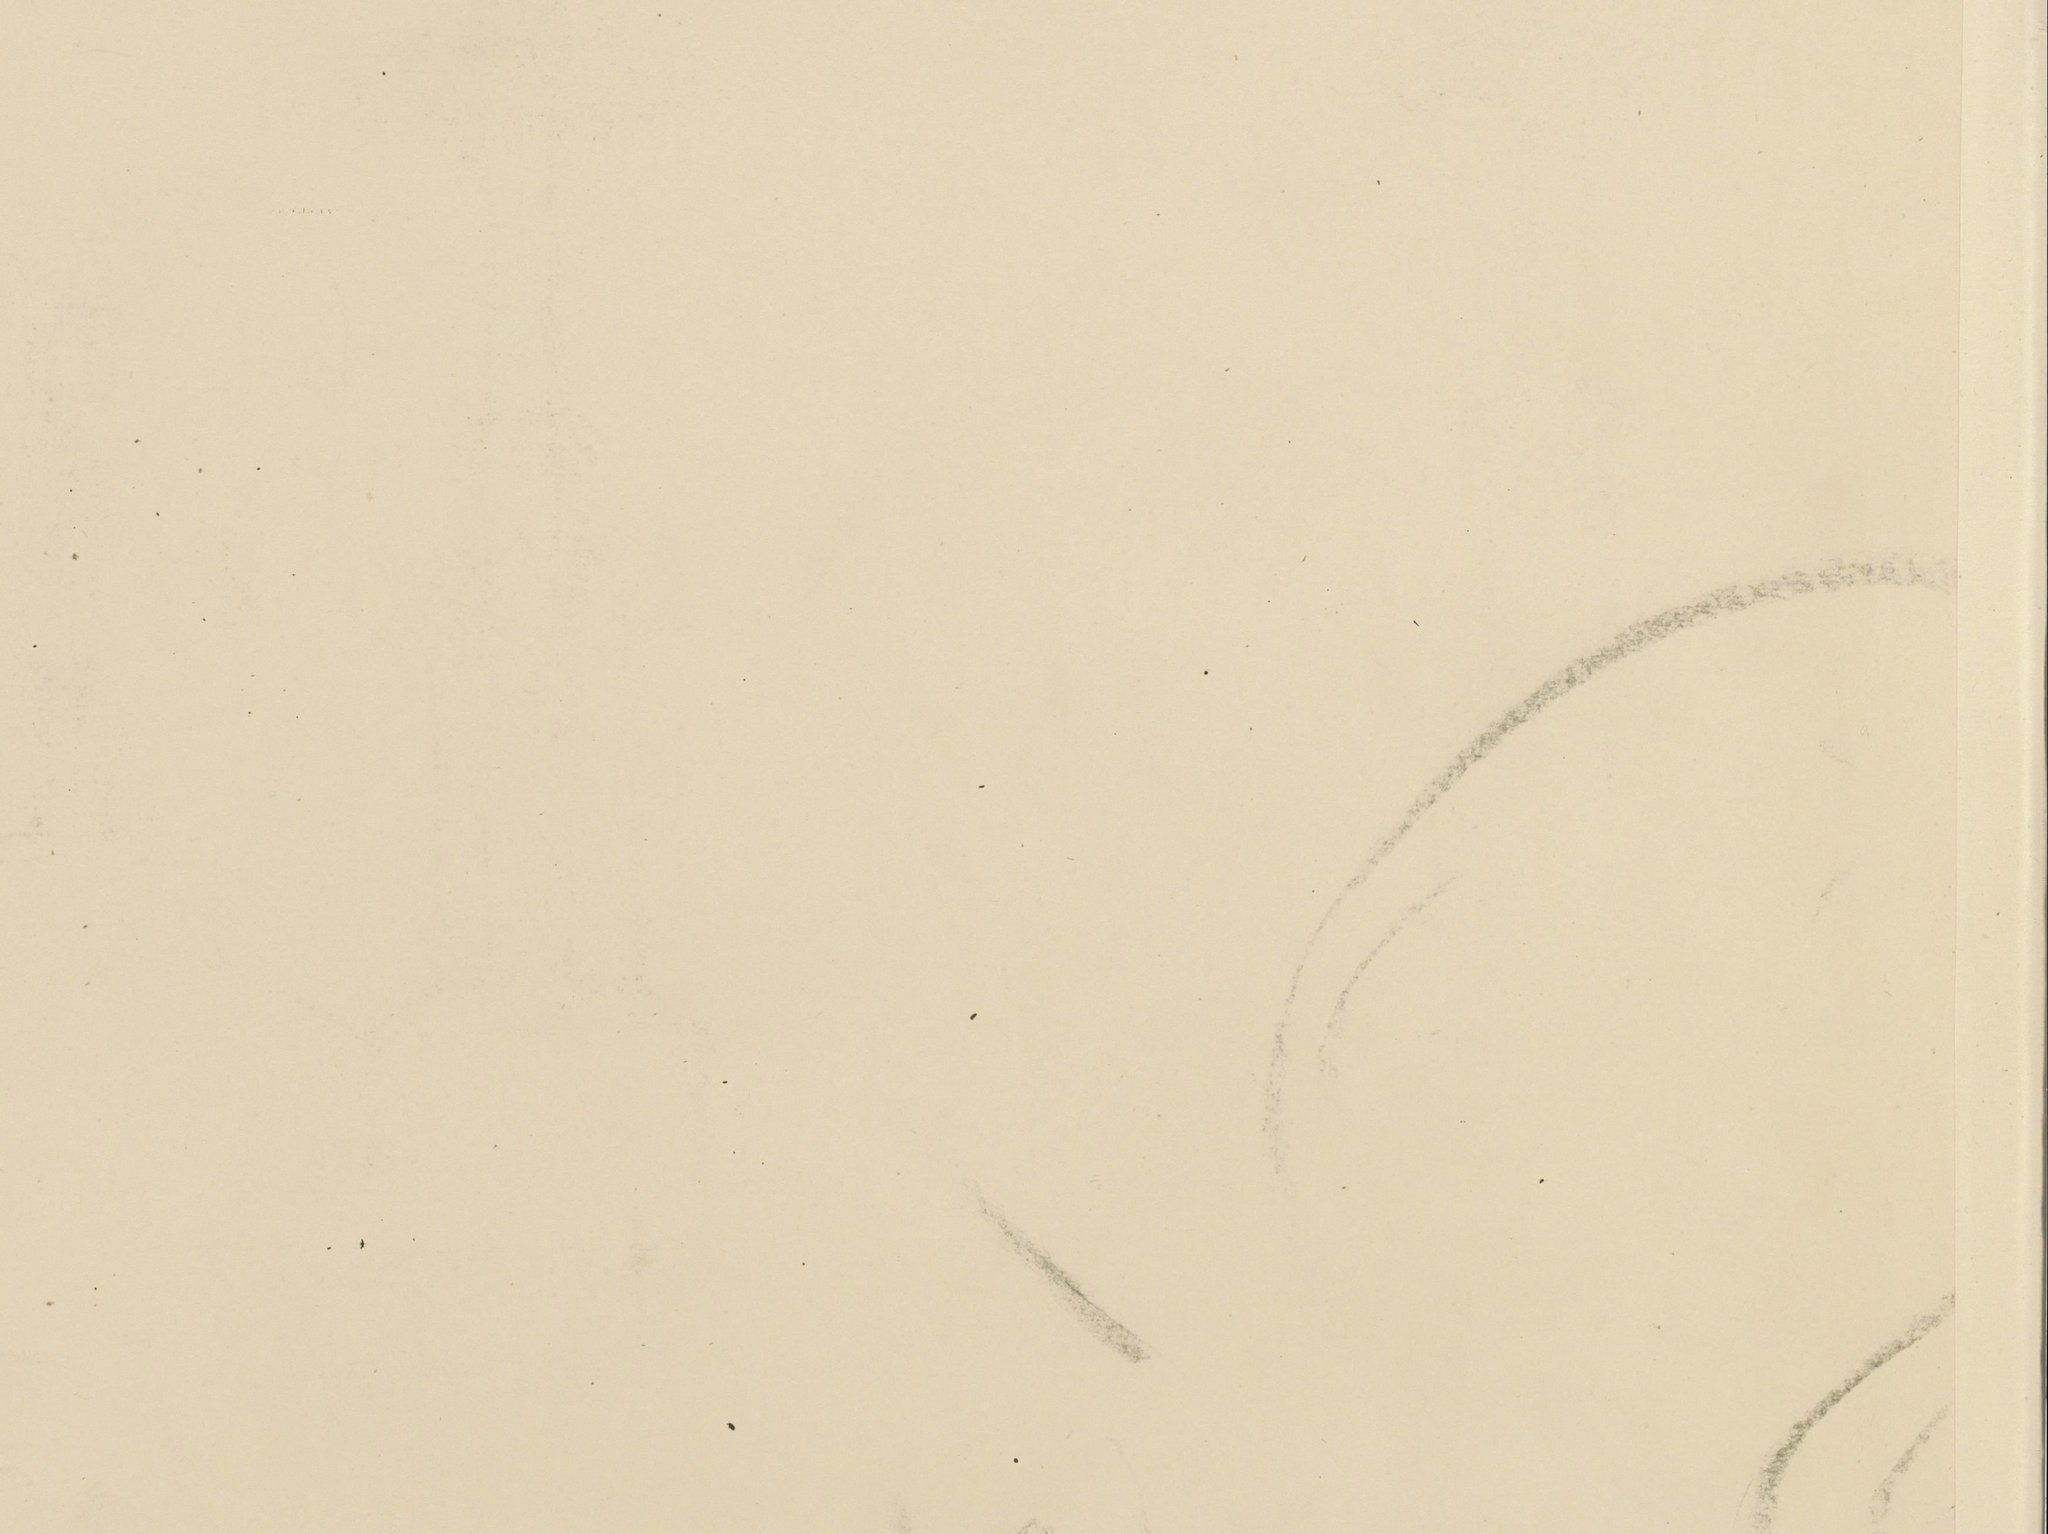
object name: sketchbook leaf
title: Reliekschrijn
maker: pierre joseph hubert cuypers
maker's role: draughtsman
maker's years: 1827-1921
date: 1850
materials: paper, pencil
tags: relics (and reliquaries)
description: Blad 24 verso uit een schetsboek met 37 bladen.